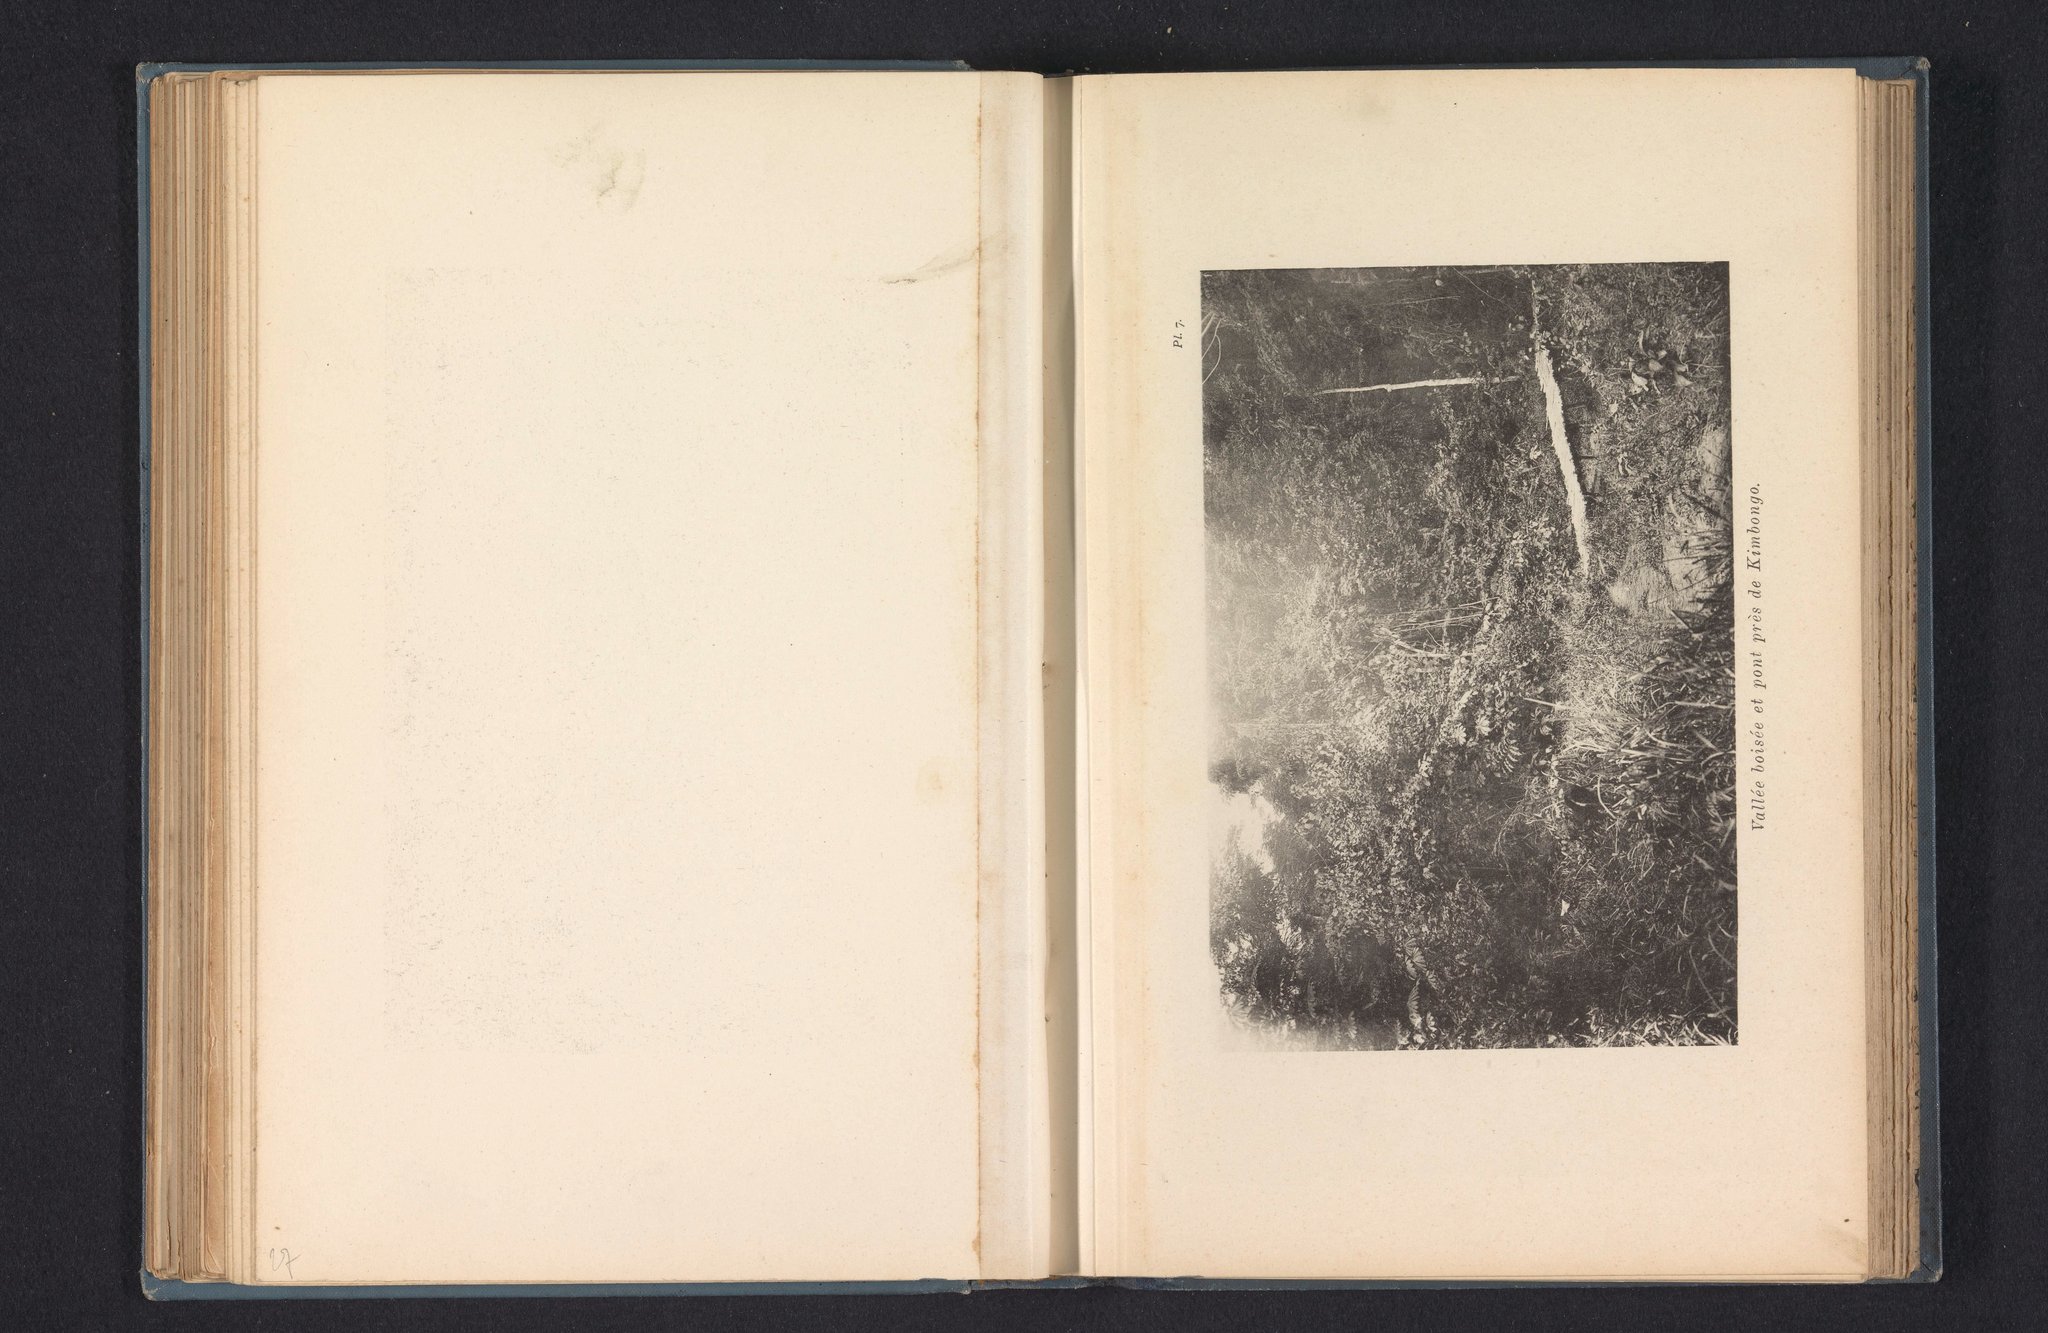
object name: page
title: Vallei met een houten brug nabij Kimbongo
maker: franz thonner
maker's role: botanicus, ontdekkingsreiziger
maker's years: 1863-1928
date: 1896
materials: paper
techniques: photograph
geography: dresden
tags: dale, valley, bridge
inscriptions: number: ‘Pl. 7.’